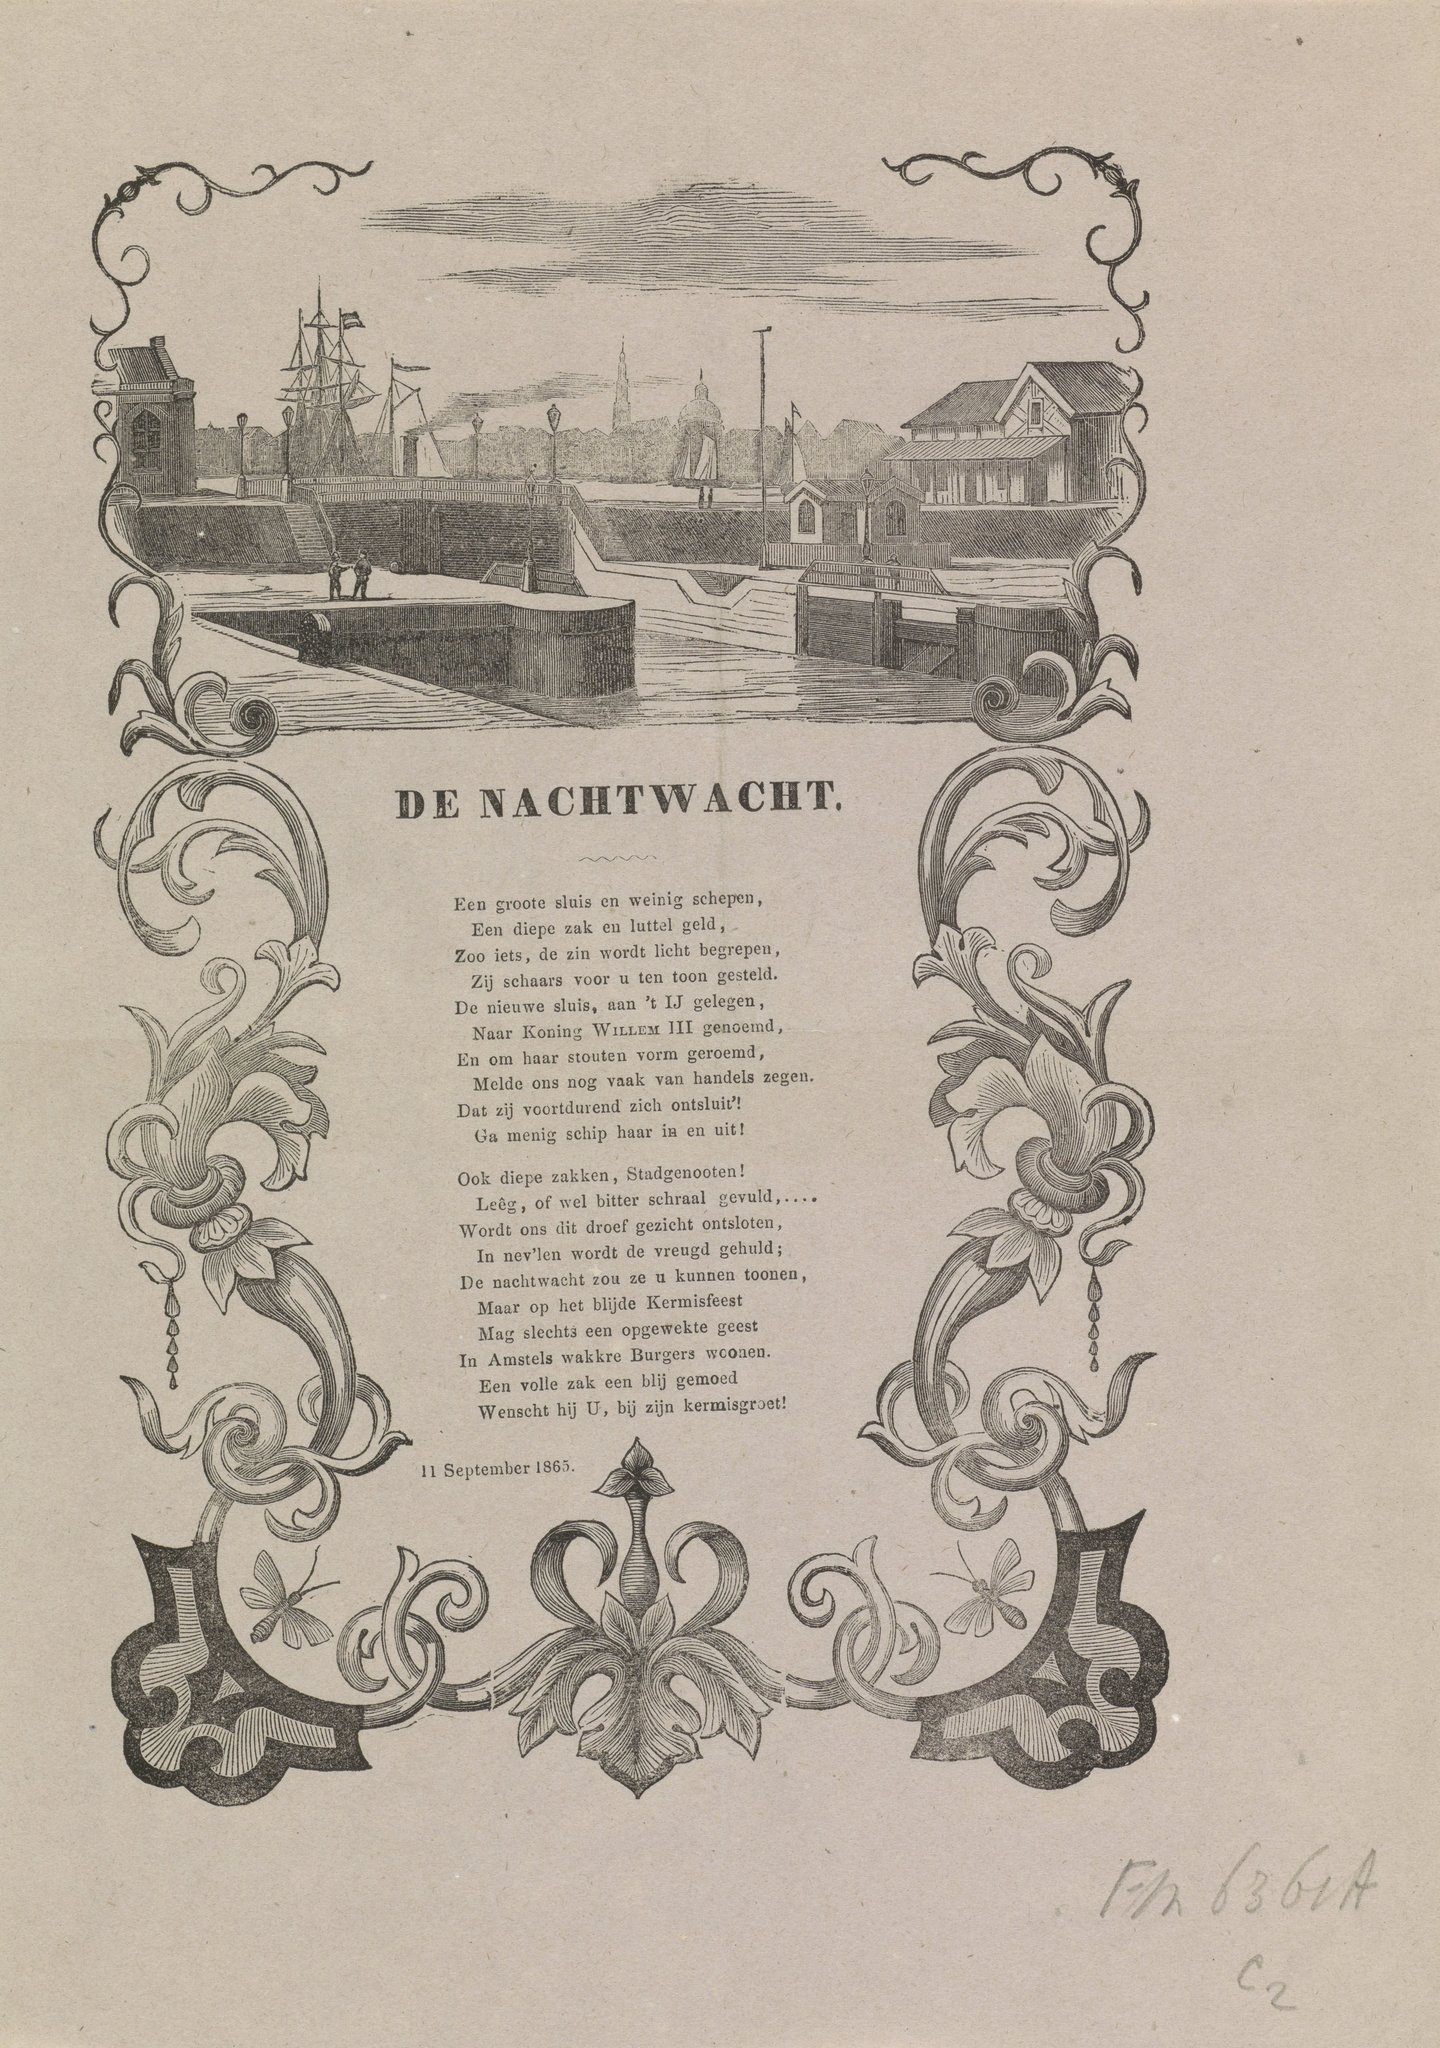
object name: fair print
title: Kermisprent van de Amsterdamse nachtwacht voor het jaar 1865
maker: Anonymous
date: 1865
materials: paper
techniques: letterpress printing, engraving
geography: netherlands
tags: sluice, weir, night patrol, amsterdam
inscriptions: collector's mark: Lugt 2228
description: Kermisprent van de Amsterdamse nachtwacht (ratelwacht), 11 september 1865. Centraal een gedicht, daarboven de nieuwe sluis aan het IJ genoemd naar koning Willem III (Willemsluizen).